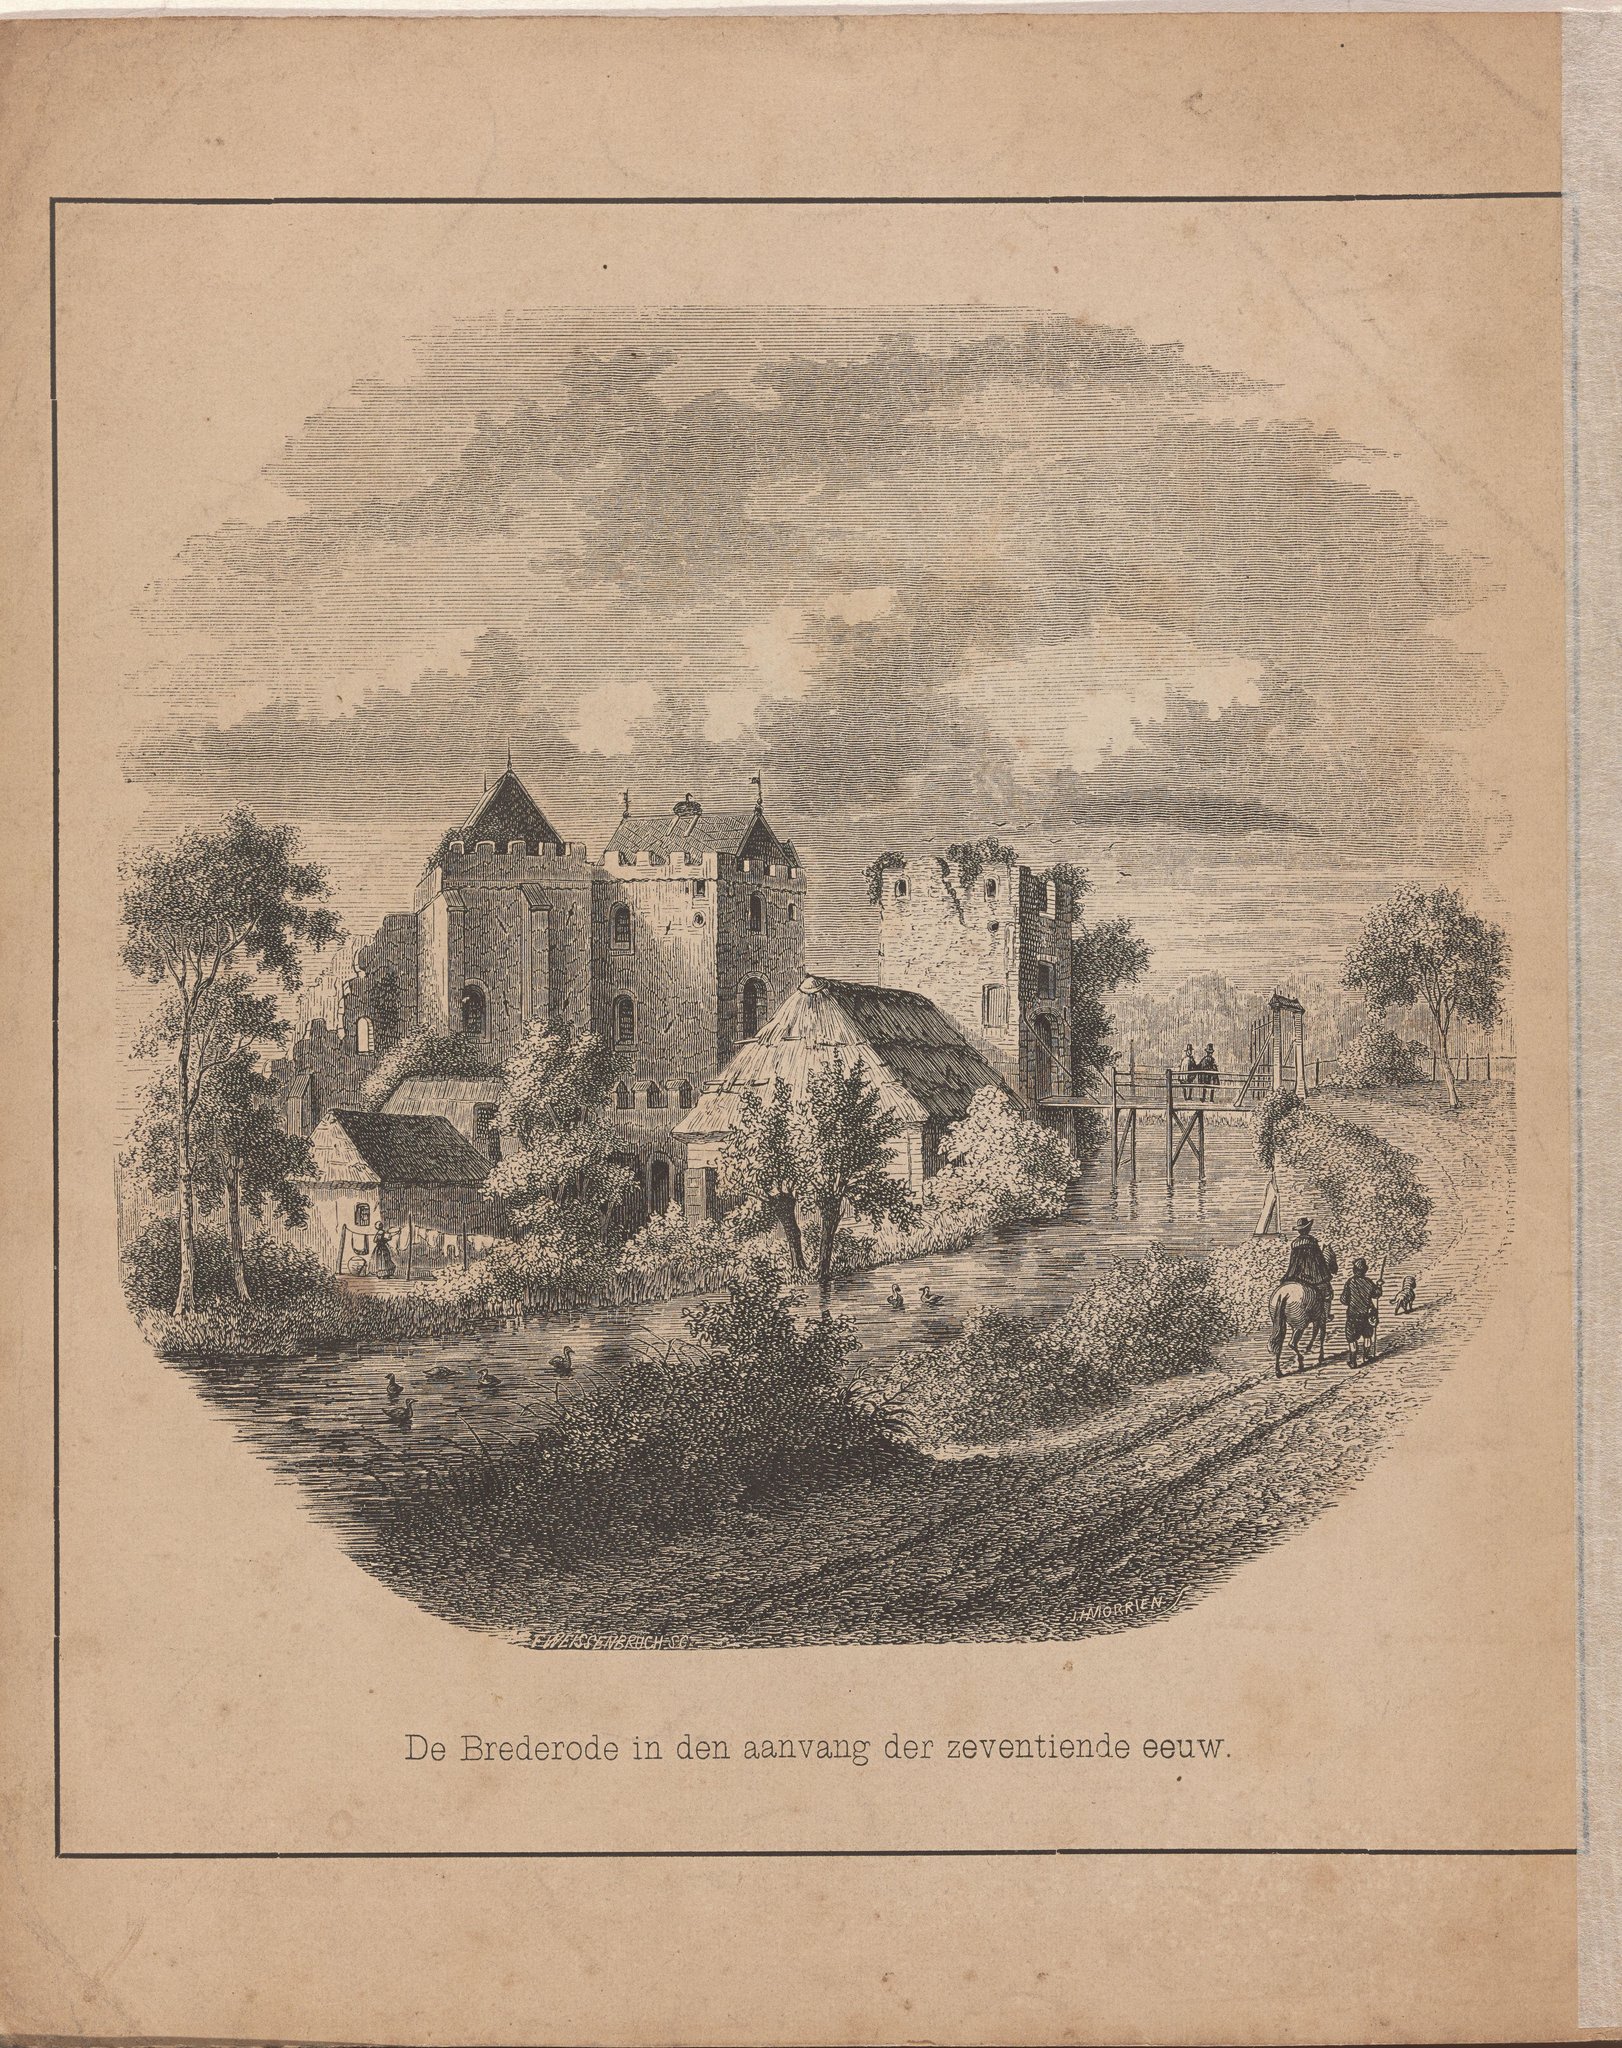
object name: print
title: De Brederode in den aanvang der zeventiende eeuw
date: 1861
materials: paper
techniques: letterpress printing, engraving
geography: amsterdam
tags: ruïne van kasteel brederode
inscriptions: collector's mark: Lugt 2228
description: Prent uit: Hofdijk, Willem Jacob. Het kasteel en de edelen van Brederode. Amsterdam: Gebr. van Es, 1861.